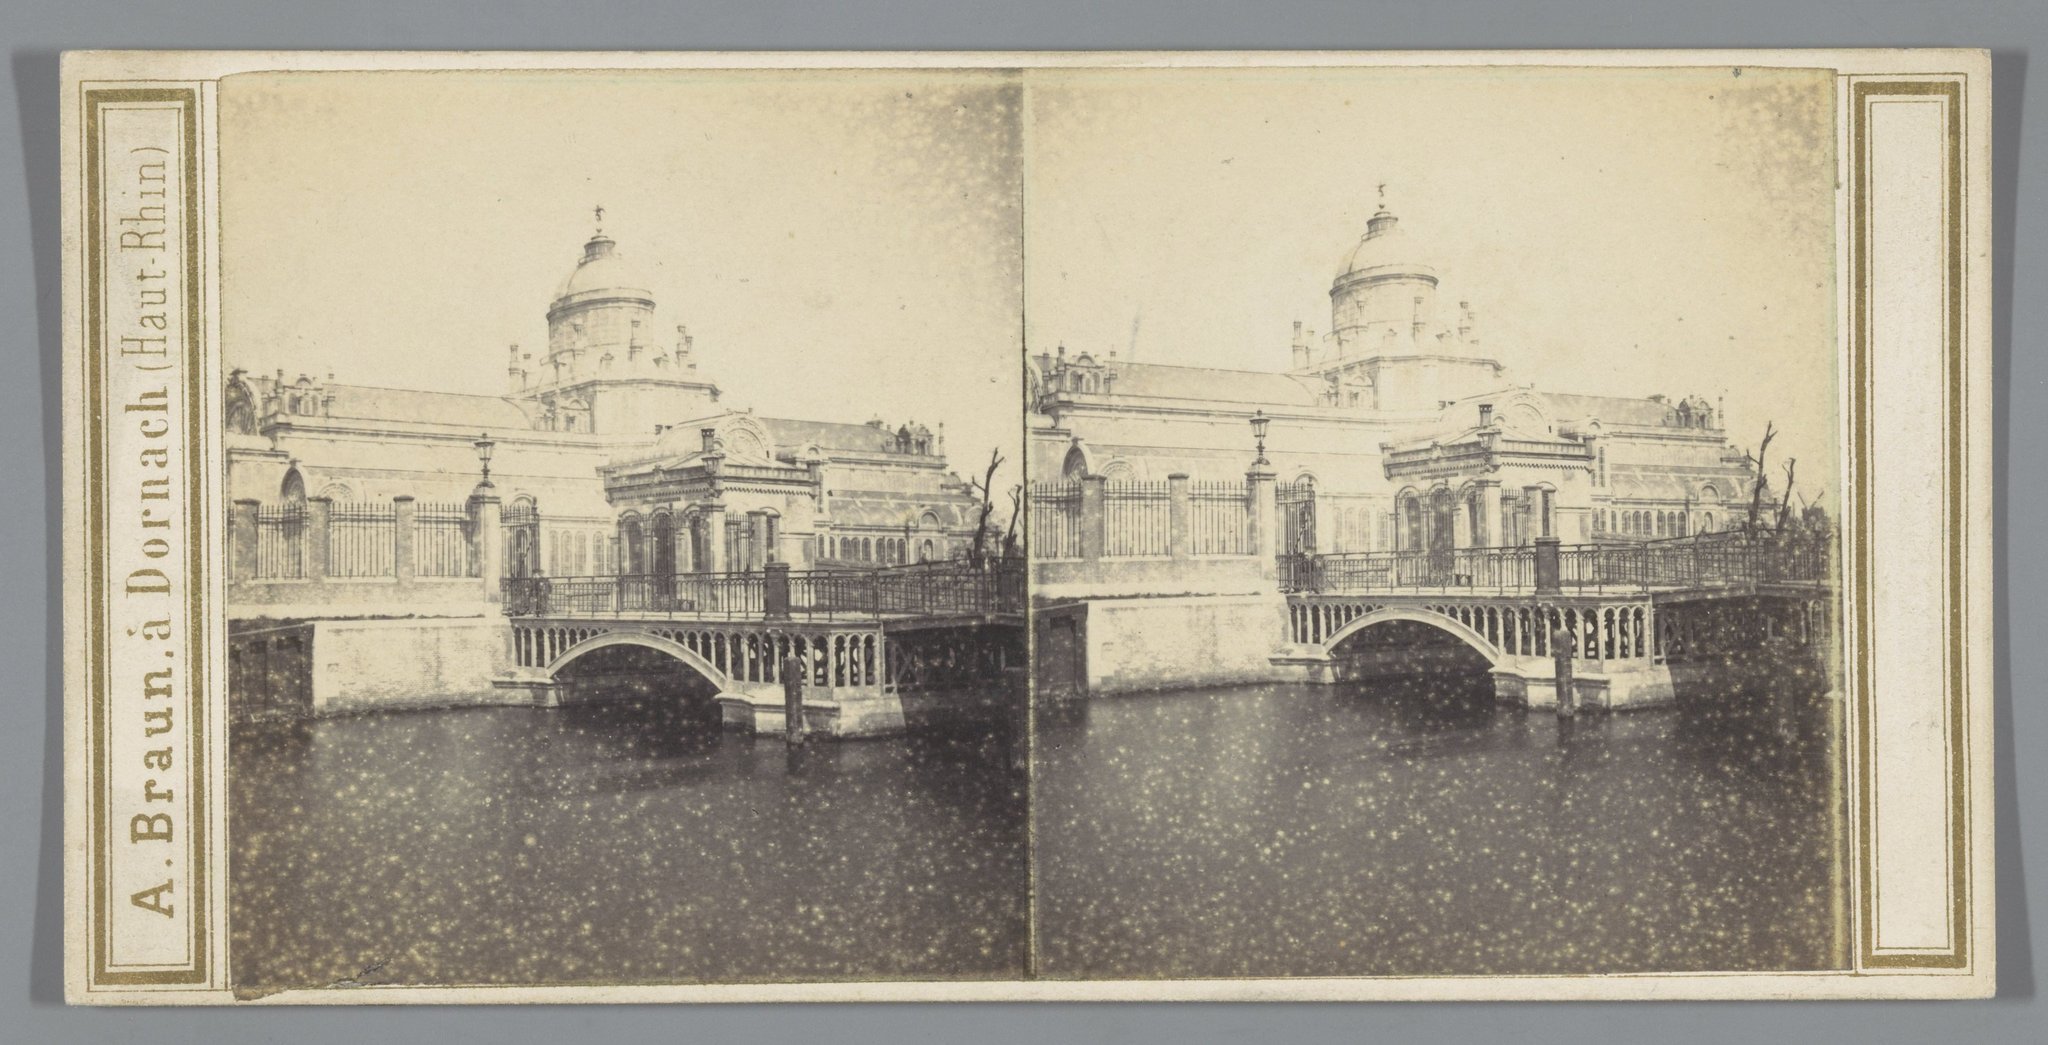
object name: stereograph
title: Amsterdam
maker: Anonymous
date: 1860-1866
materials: cardboard, paper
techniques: albumen print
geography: dornach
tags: palace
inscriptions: number: ‘No. 3965.’, number: ‘80’, inscription: ‘6de Ramts’